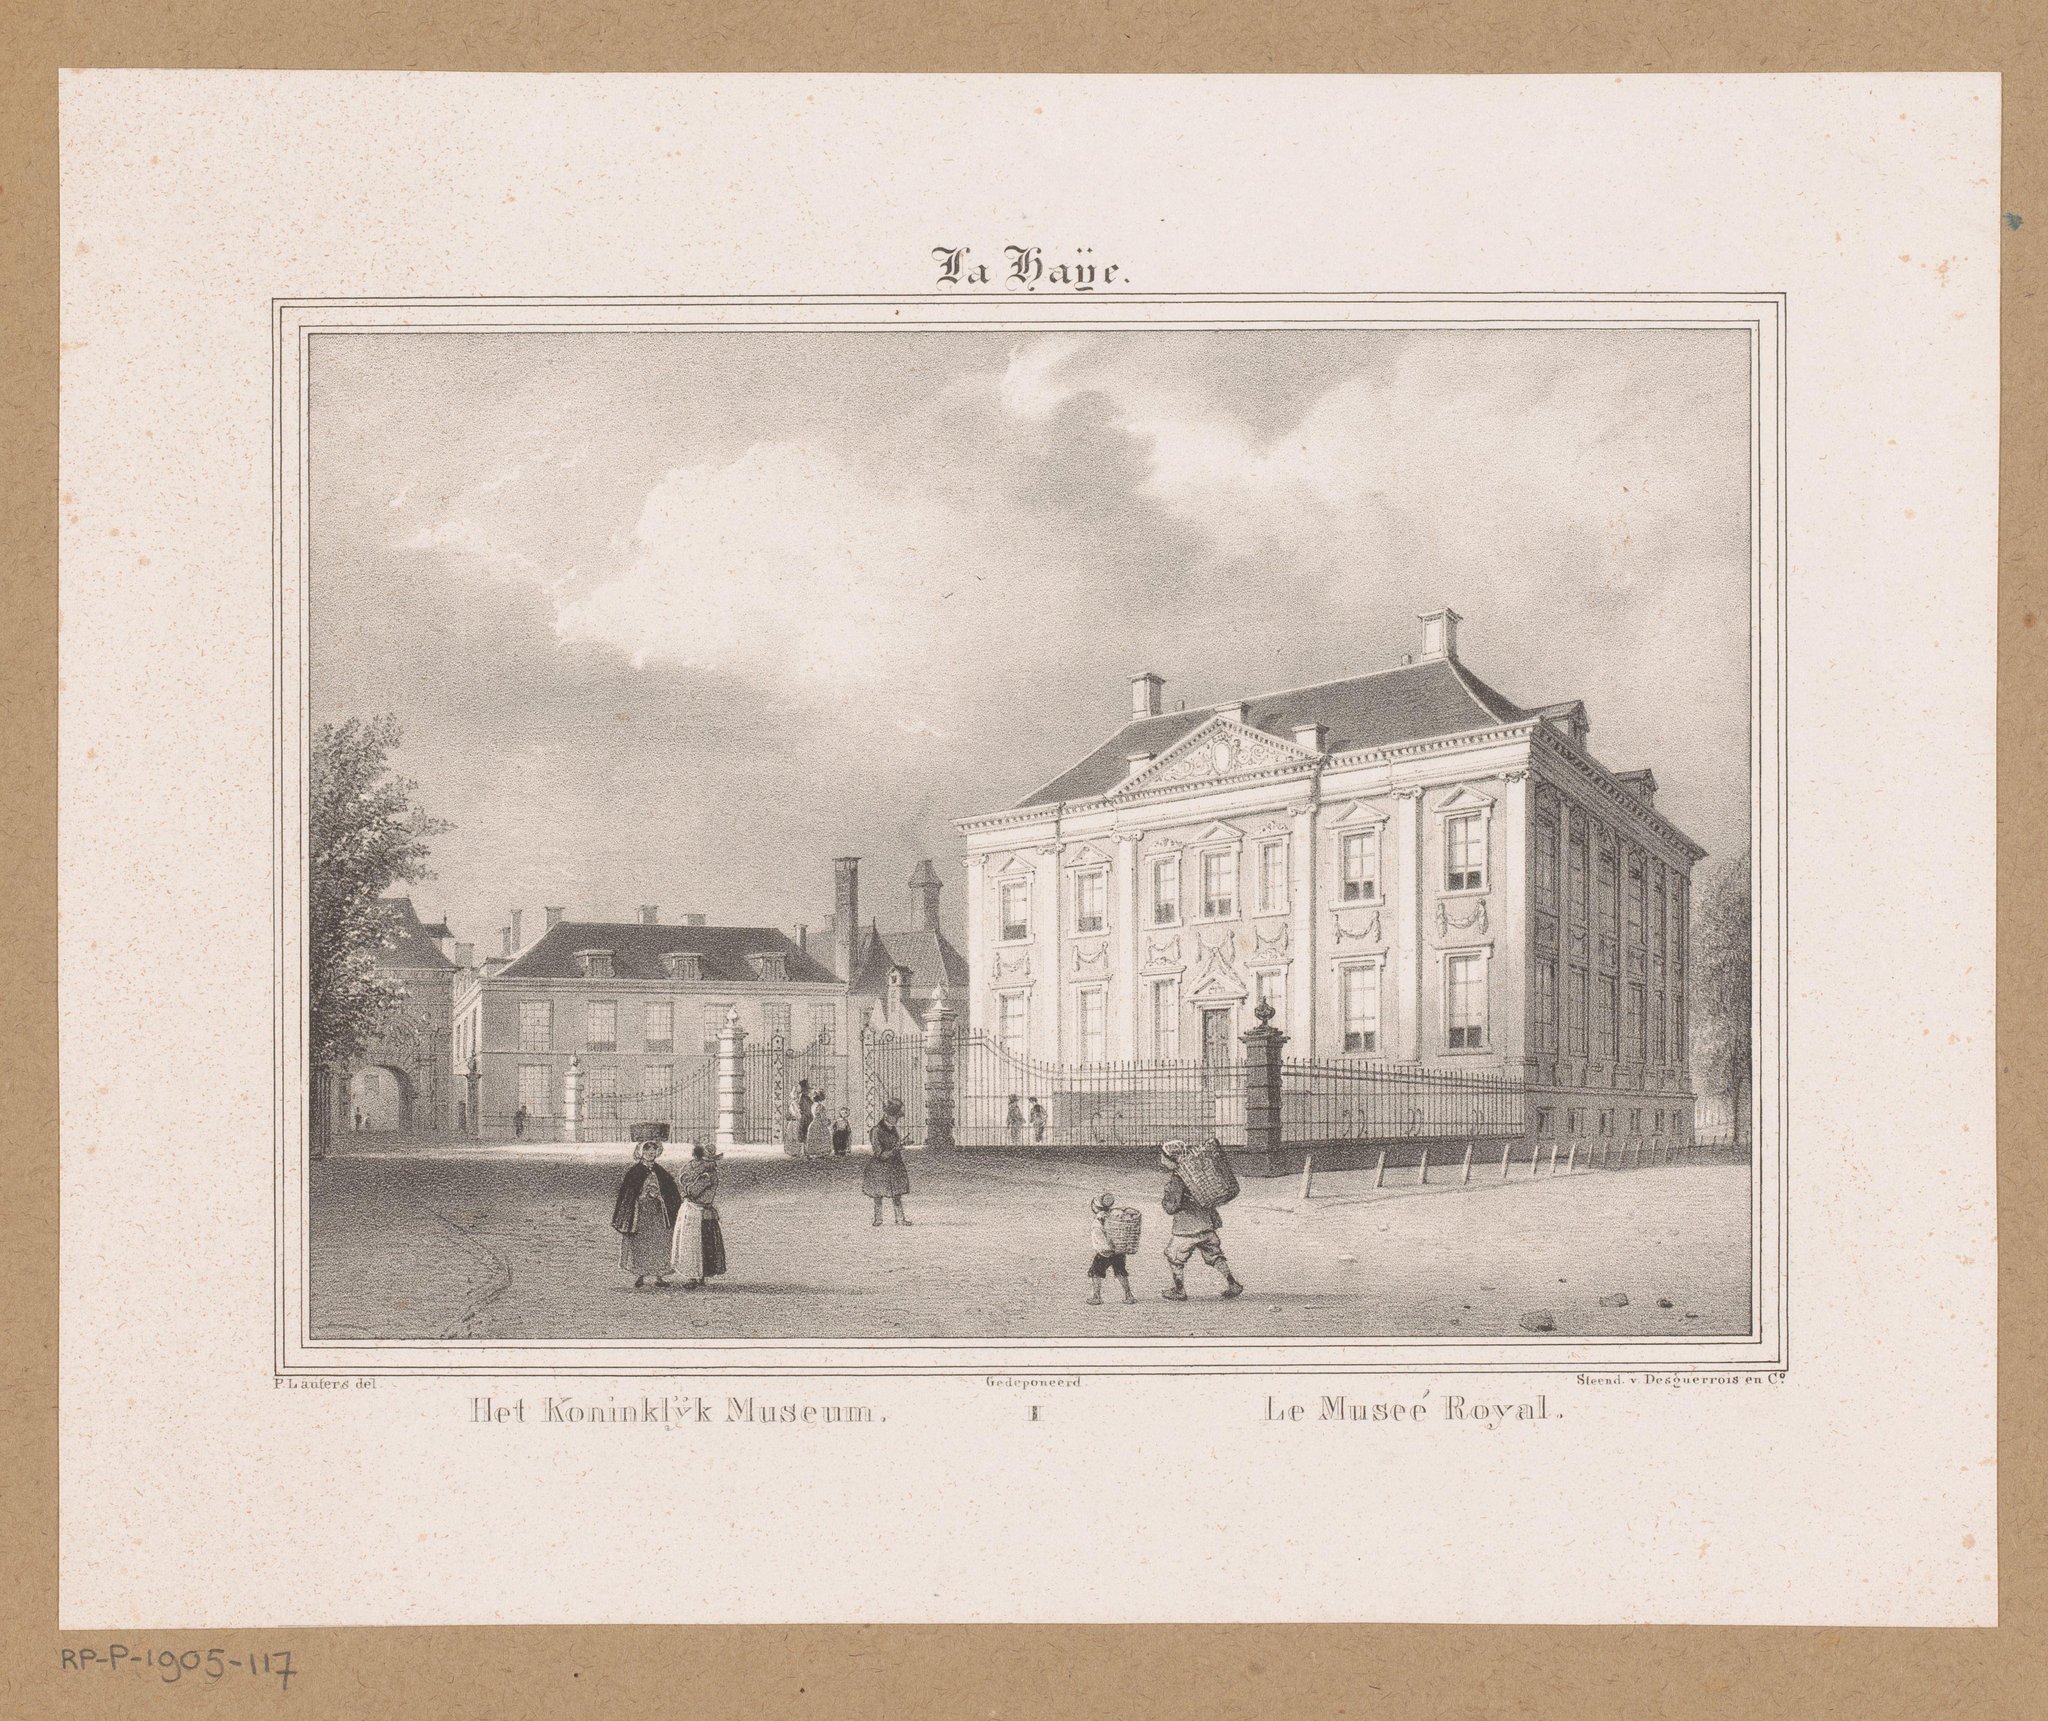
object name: print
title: Het Koninklÿk Museum / Le Museé Royal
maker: paulus lauters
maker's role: print maker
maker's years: 1806-1875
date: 1836-1840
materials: paper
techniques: lithograph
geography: amsterdam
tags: city-view in general; 'veduta', permanent exhibition, museum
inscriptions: : ‘Gedeponeerd’, collector's mark: Lugt 2228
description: Prent maakt onderdeel uit van de serie: Hoofdgebouwen en gezichten der Voornaamste Steden van Holland. Onder deze naam werden in ieder geval verschillende stadgezichten gepubliceerd in de jaren 1836, 1839 en 1840 door Desguerrois & Co.